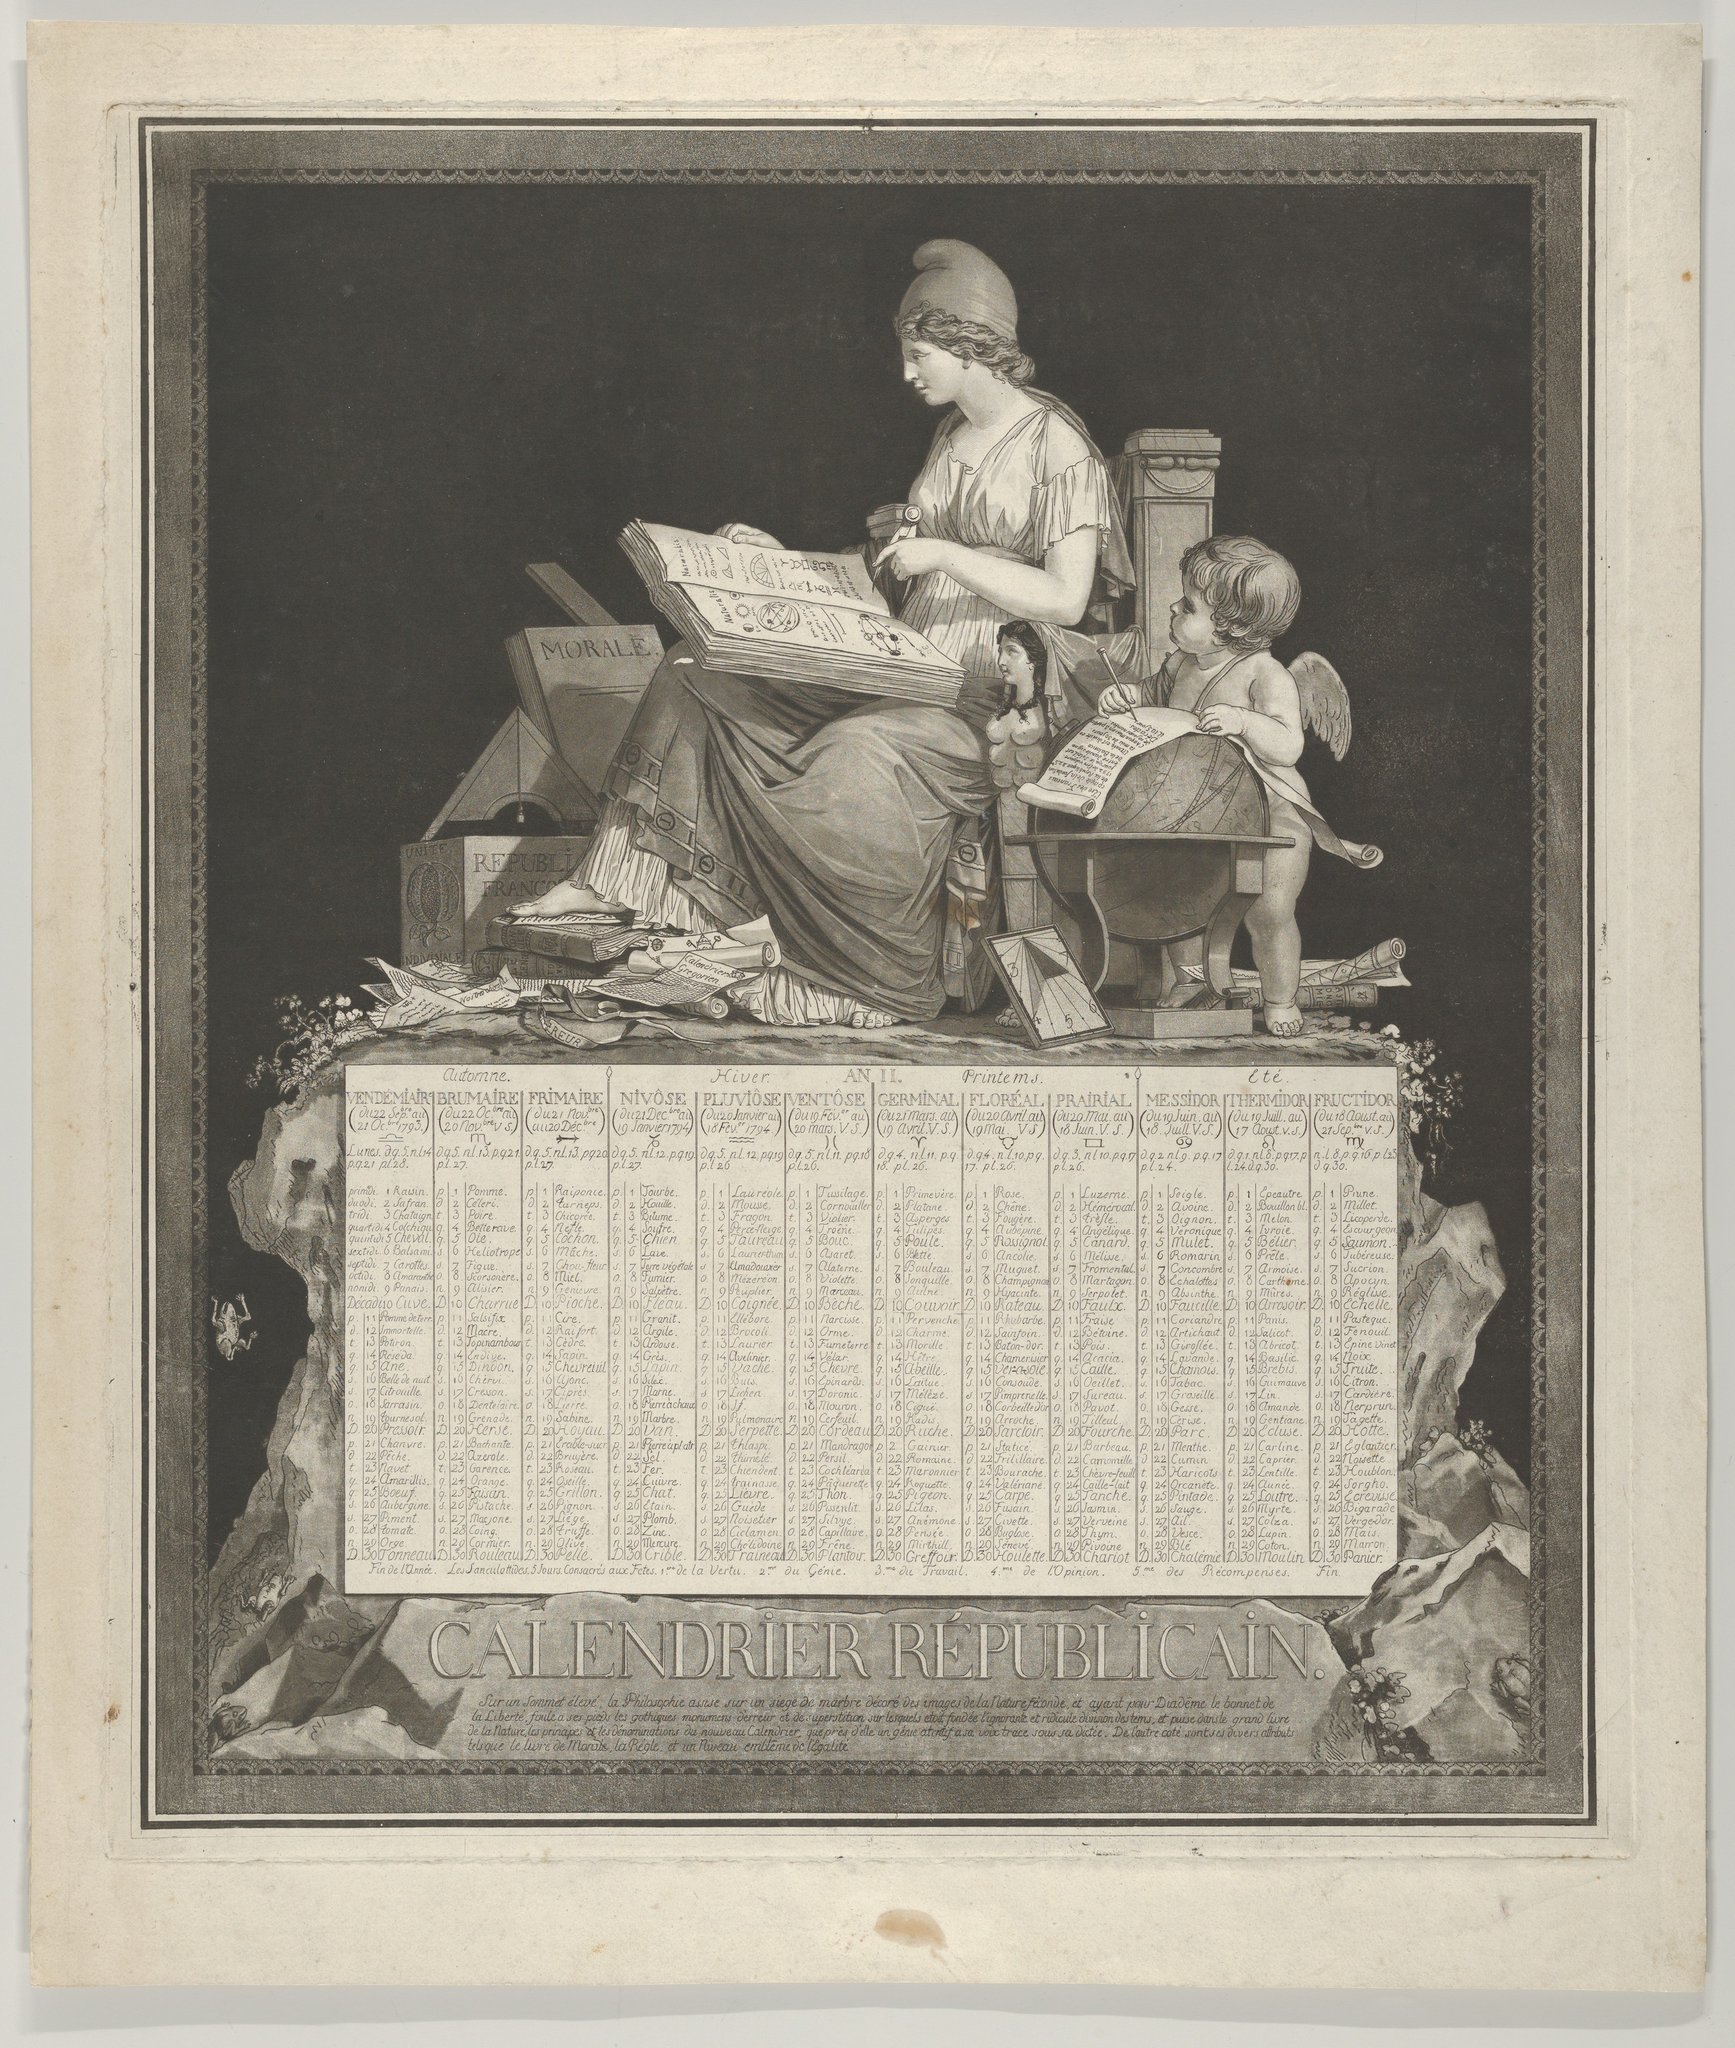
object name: print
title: Revolutionary Calendar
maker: louis philibert debucourt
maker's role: artist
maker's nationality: french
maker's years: 1755-1832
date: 1793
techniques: aquatint, etching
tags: women,calendars